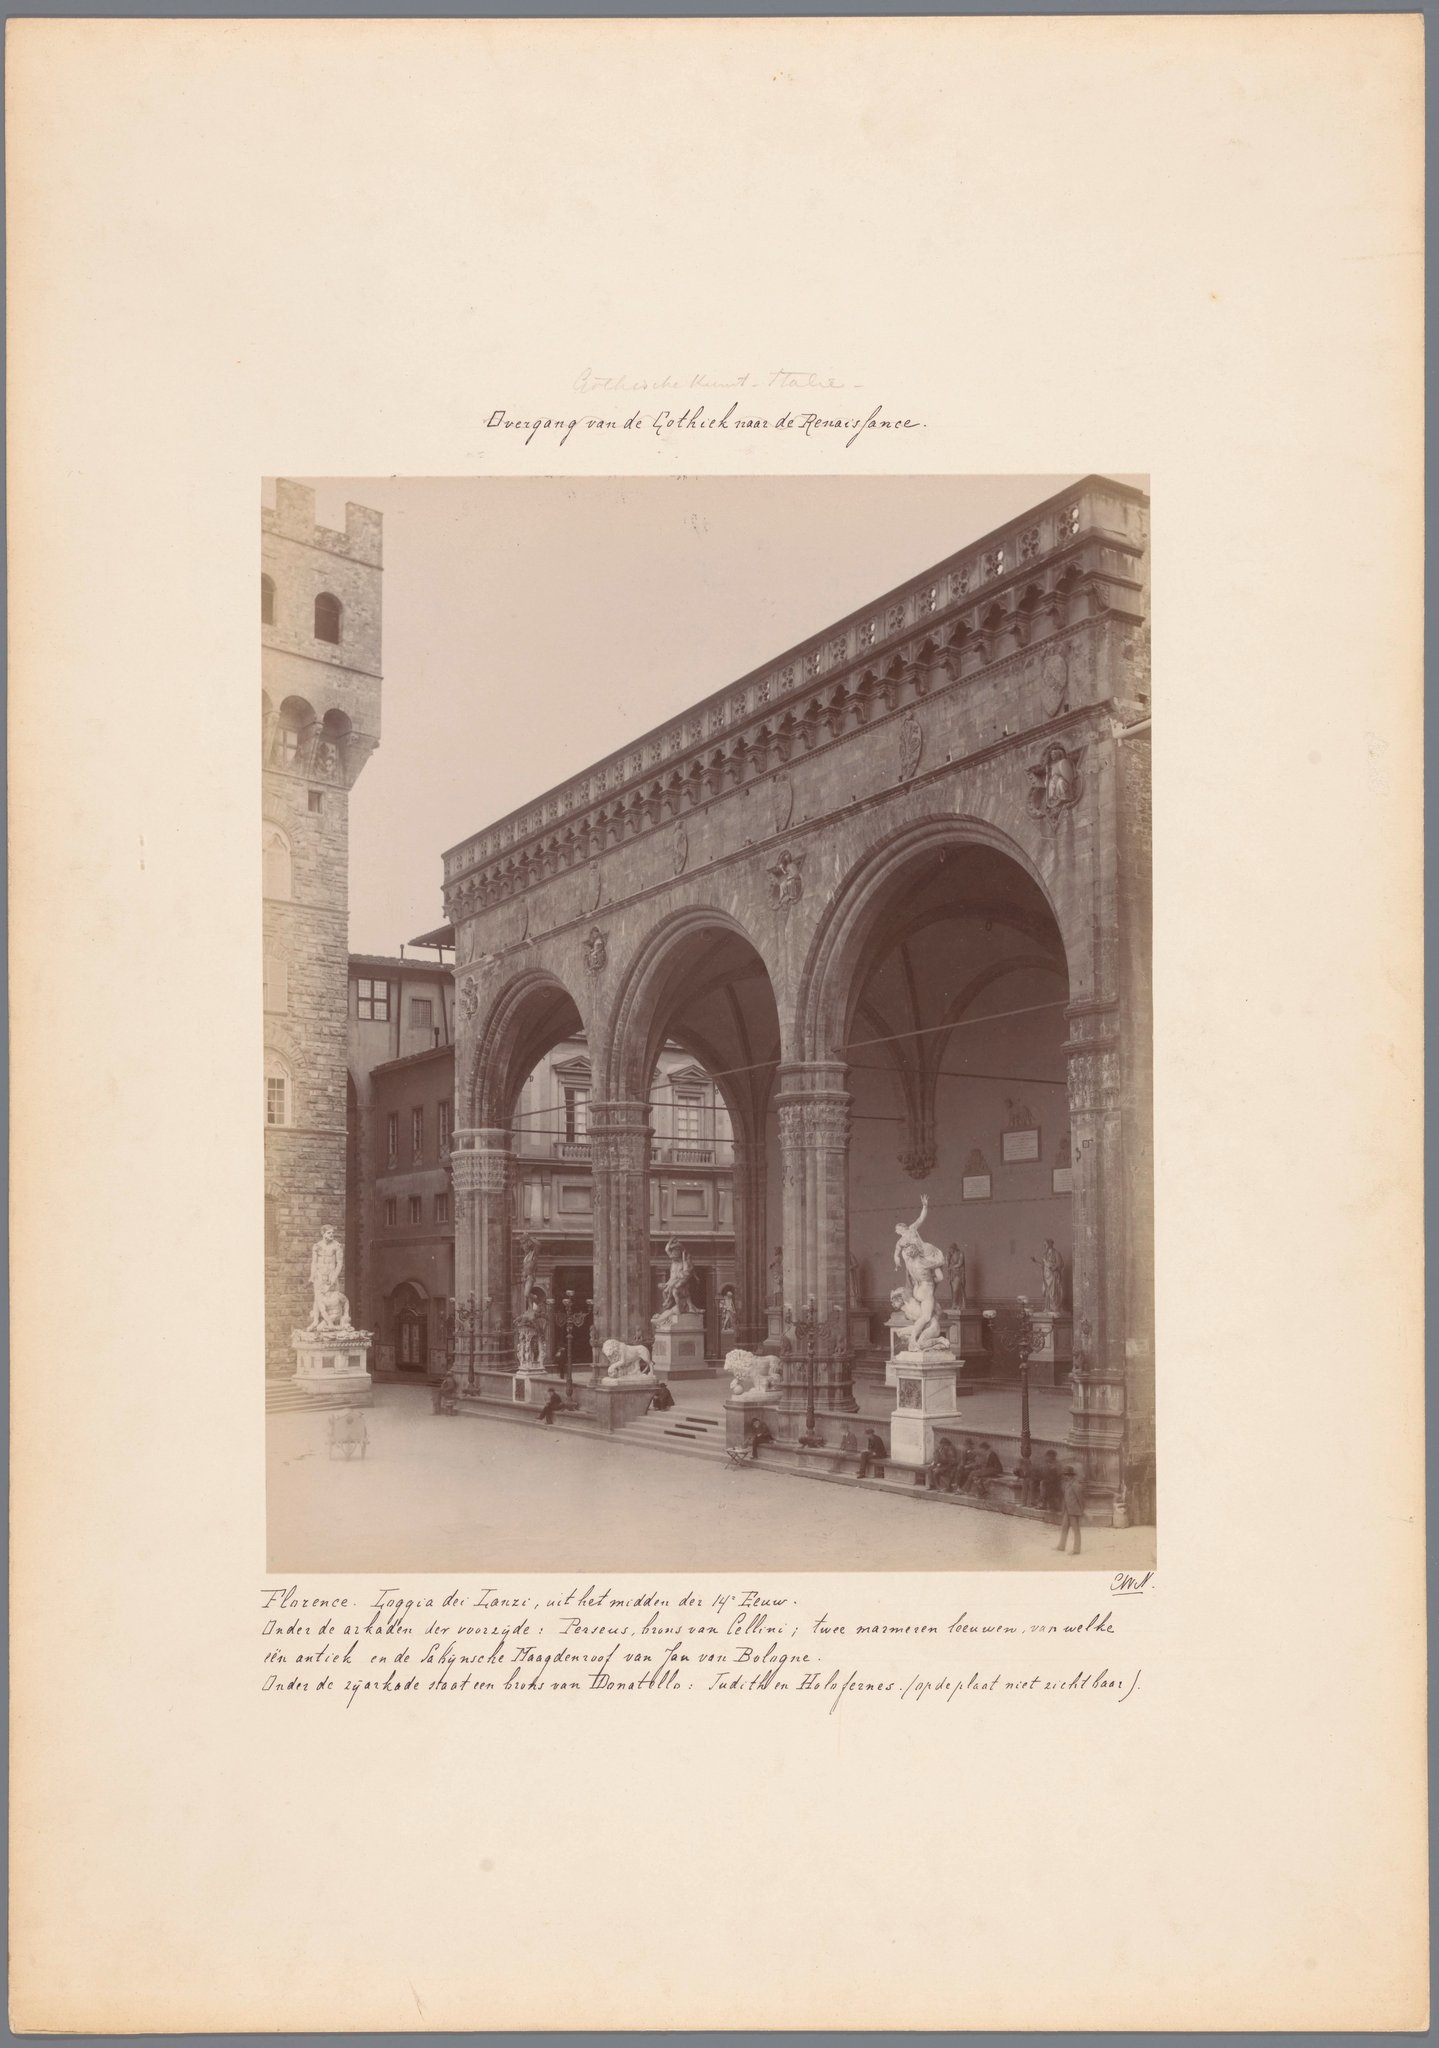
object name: photograph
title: Gezicht op de Loggia dei Lanzi te Florence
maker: Anonymous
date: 1875-1900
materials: cardboard, photographic support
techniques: albumen print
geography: florence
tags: hand-cart, piece of sculpture, reproduction of a piece of sculpture, loggia, verandah, porch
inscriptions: collector's mark: ‘INSTITUUT VOOR KUNST-NIJVERHEIDSONDERWIJS GABRIËL METSUSTRAAT No. 16 AMSTERDAM’, collector's mark: ‘KUNSTNIJVERHEIDSCHOOL QUELLINUS AMSTERDAM FRANS HALSSTRAAT 14.’, inscription: ‘Gotische Kunst. Italië.’, inscription: ‘CWN.’